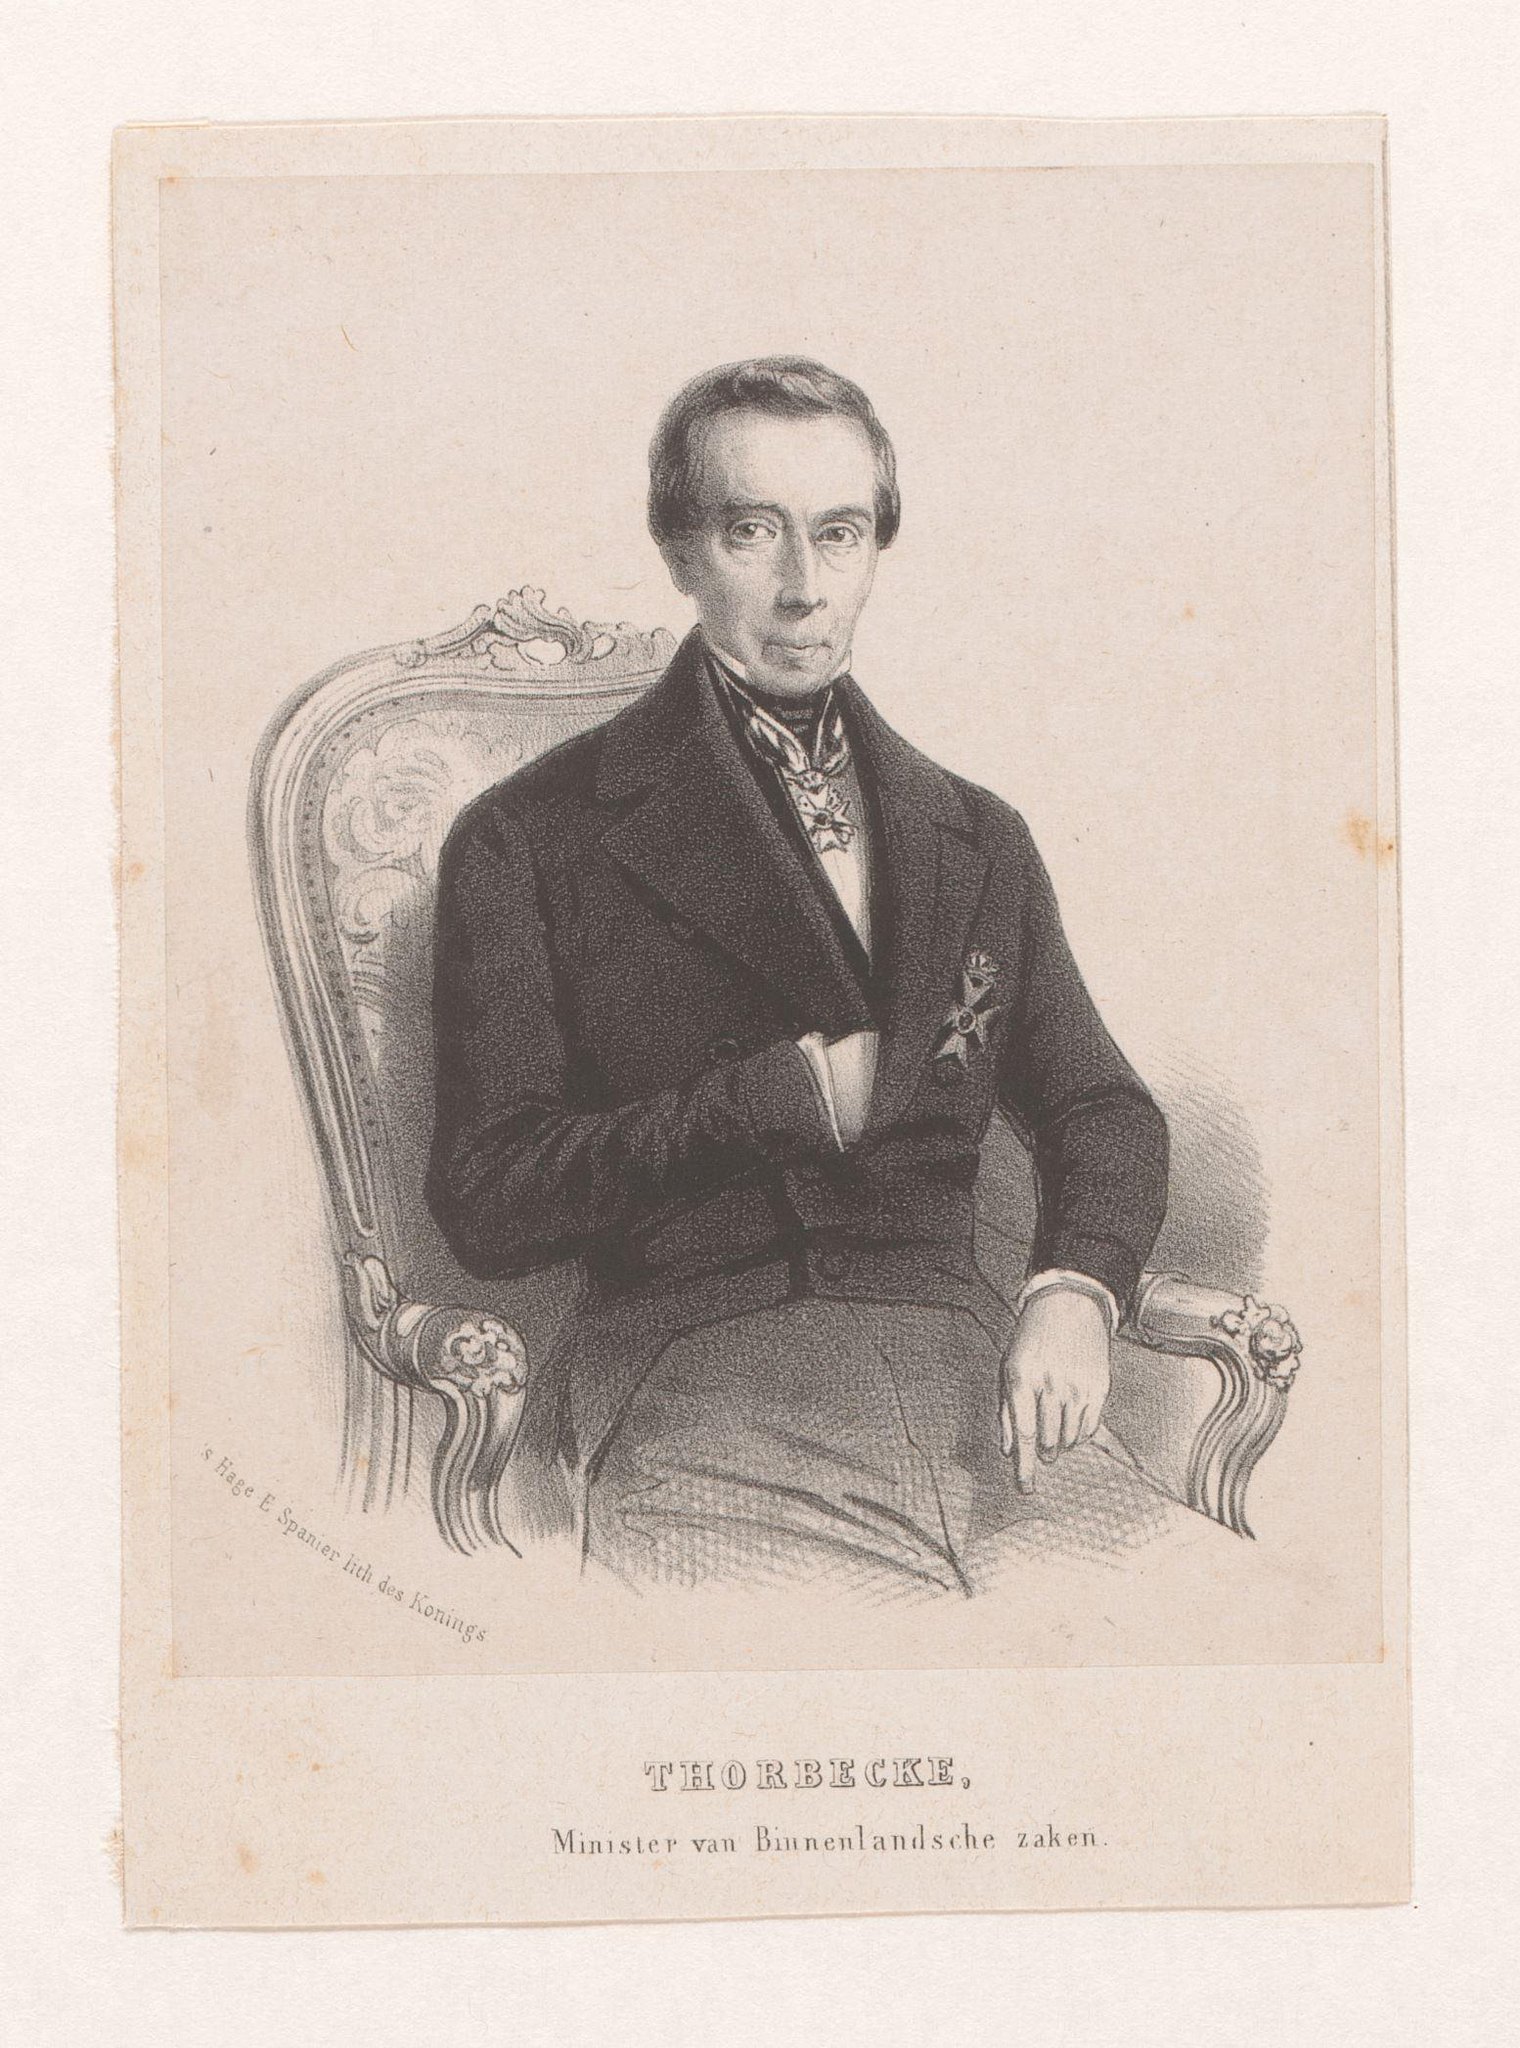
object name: print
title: Portret van Johan Rudolf Thorbecke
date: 1831-1863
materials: paper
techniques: lithograph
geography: the hague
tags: the hague, johan rudolf thorbecke, minister ~ government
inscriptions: collector's mark: Lugt 2228